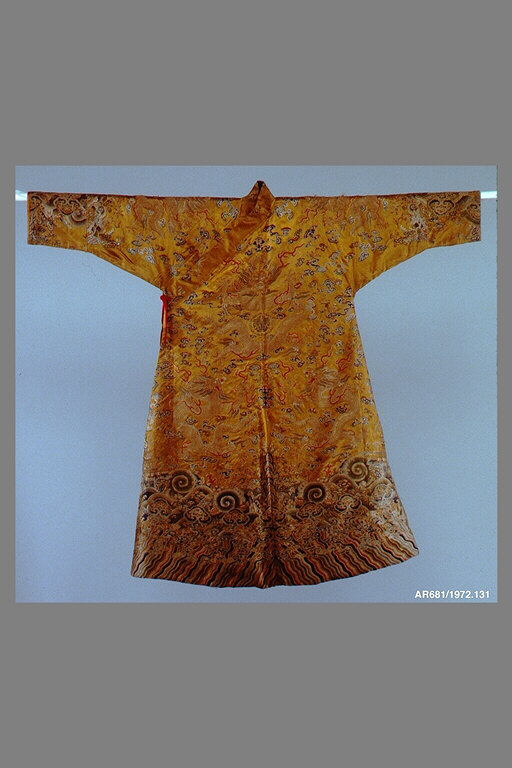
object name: lay aristocrat's robe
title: Lay aristocrat's robe (Chuba)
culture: tibetan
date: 1701-1800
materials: gold, silk